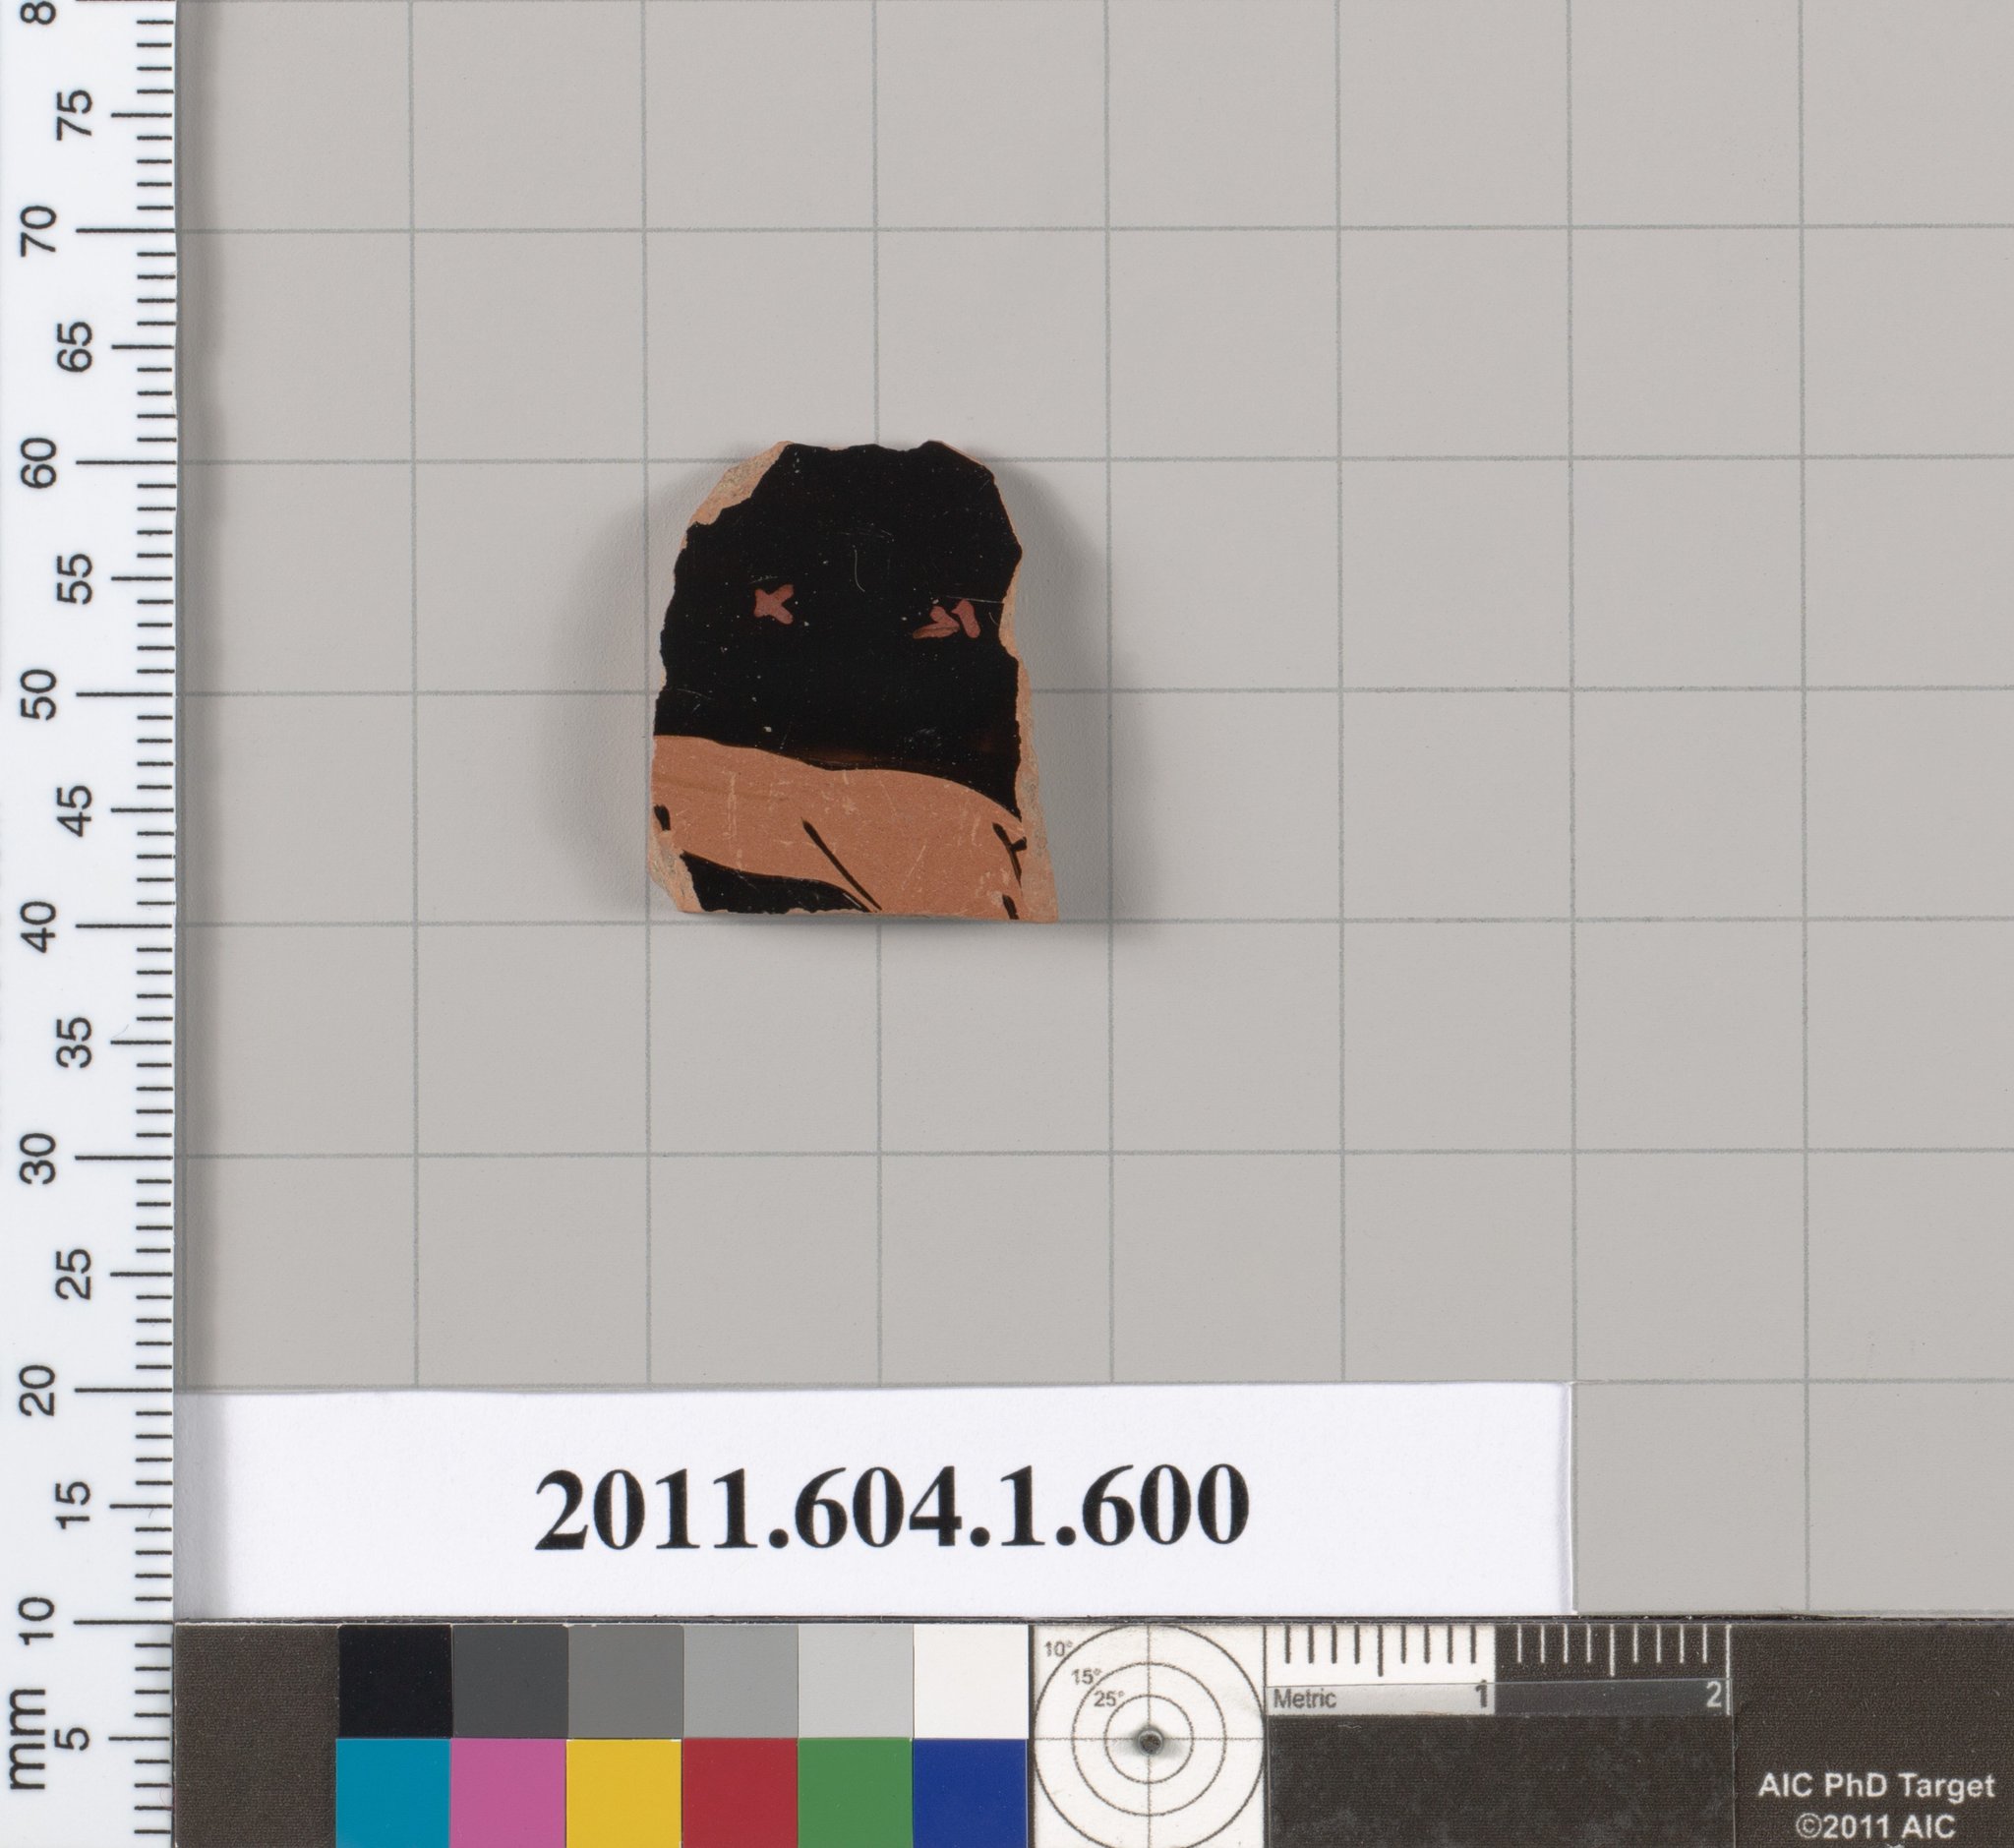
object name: kylix fragment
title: Terracotta fragment of a kylix (drinking cup)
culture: greek, attic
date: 475-451 BCE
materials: terracotta